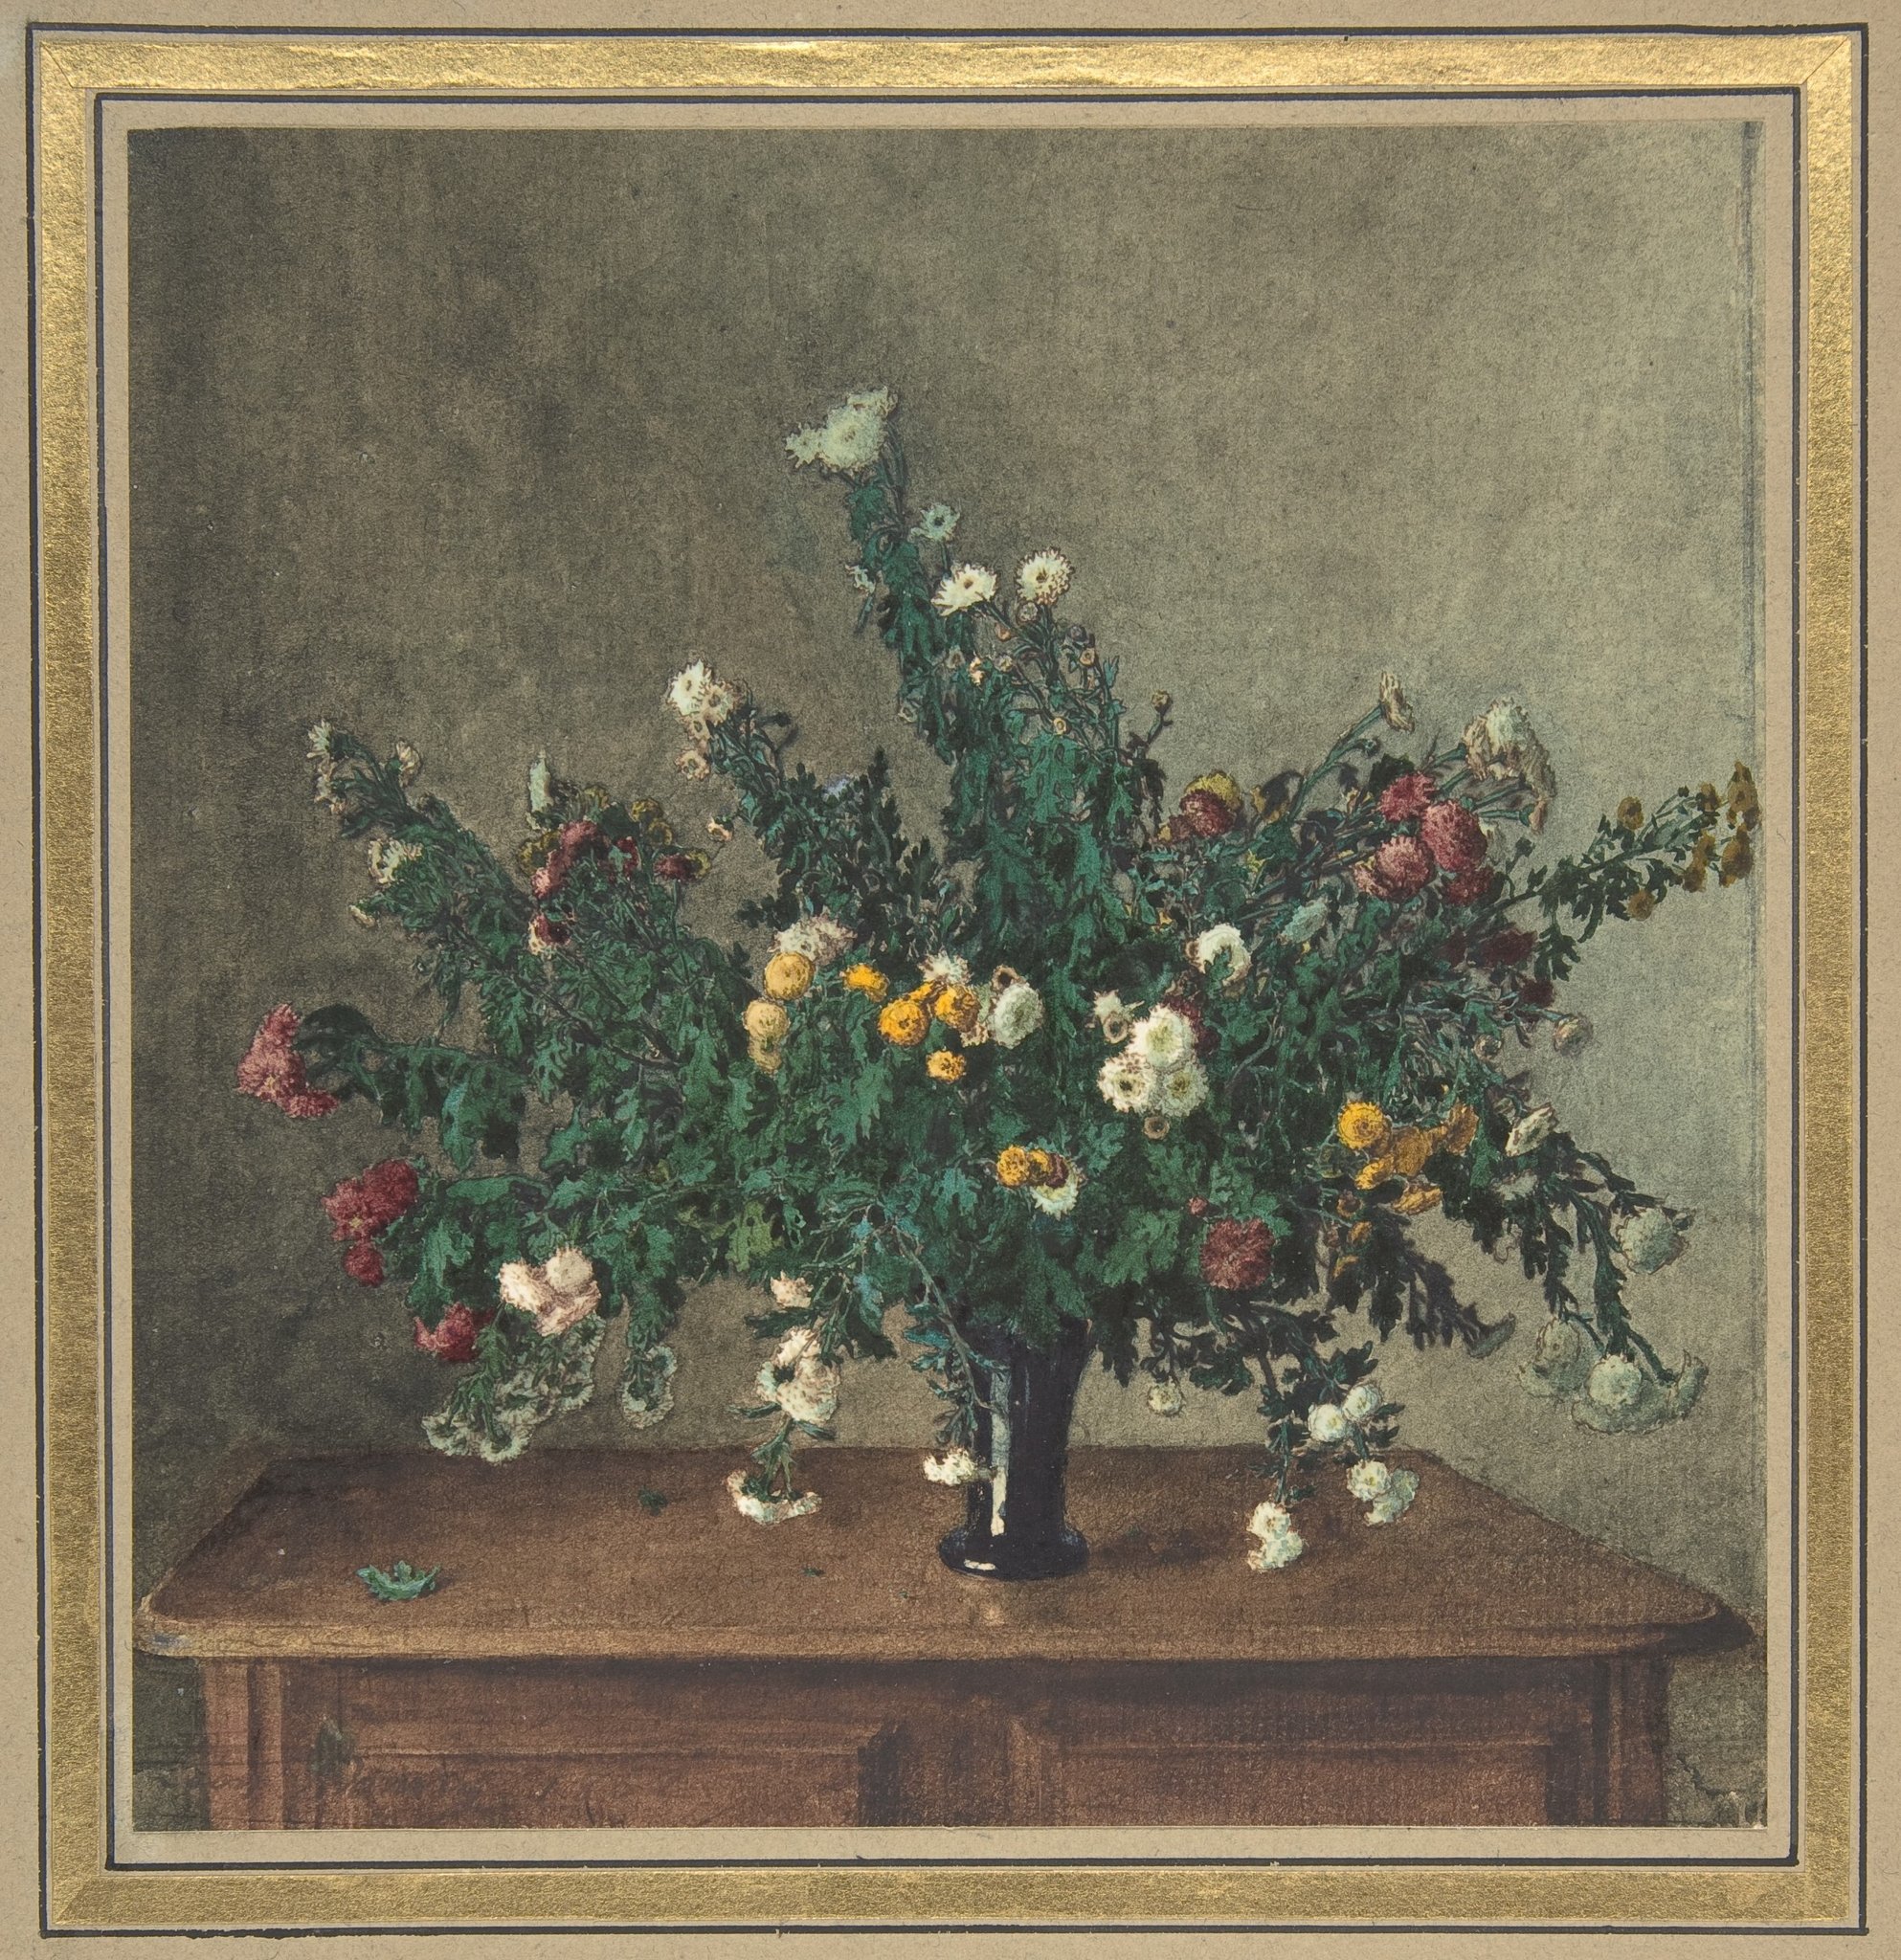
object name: drawing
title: Bouquet of Small Chrysanthemums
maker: léon bonvin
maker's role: artist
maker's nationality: french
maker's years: 1834-1866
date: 1862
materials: gouache, watercolor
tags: flowers,still life